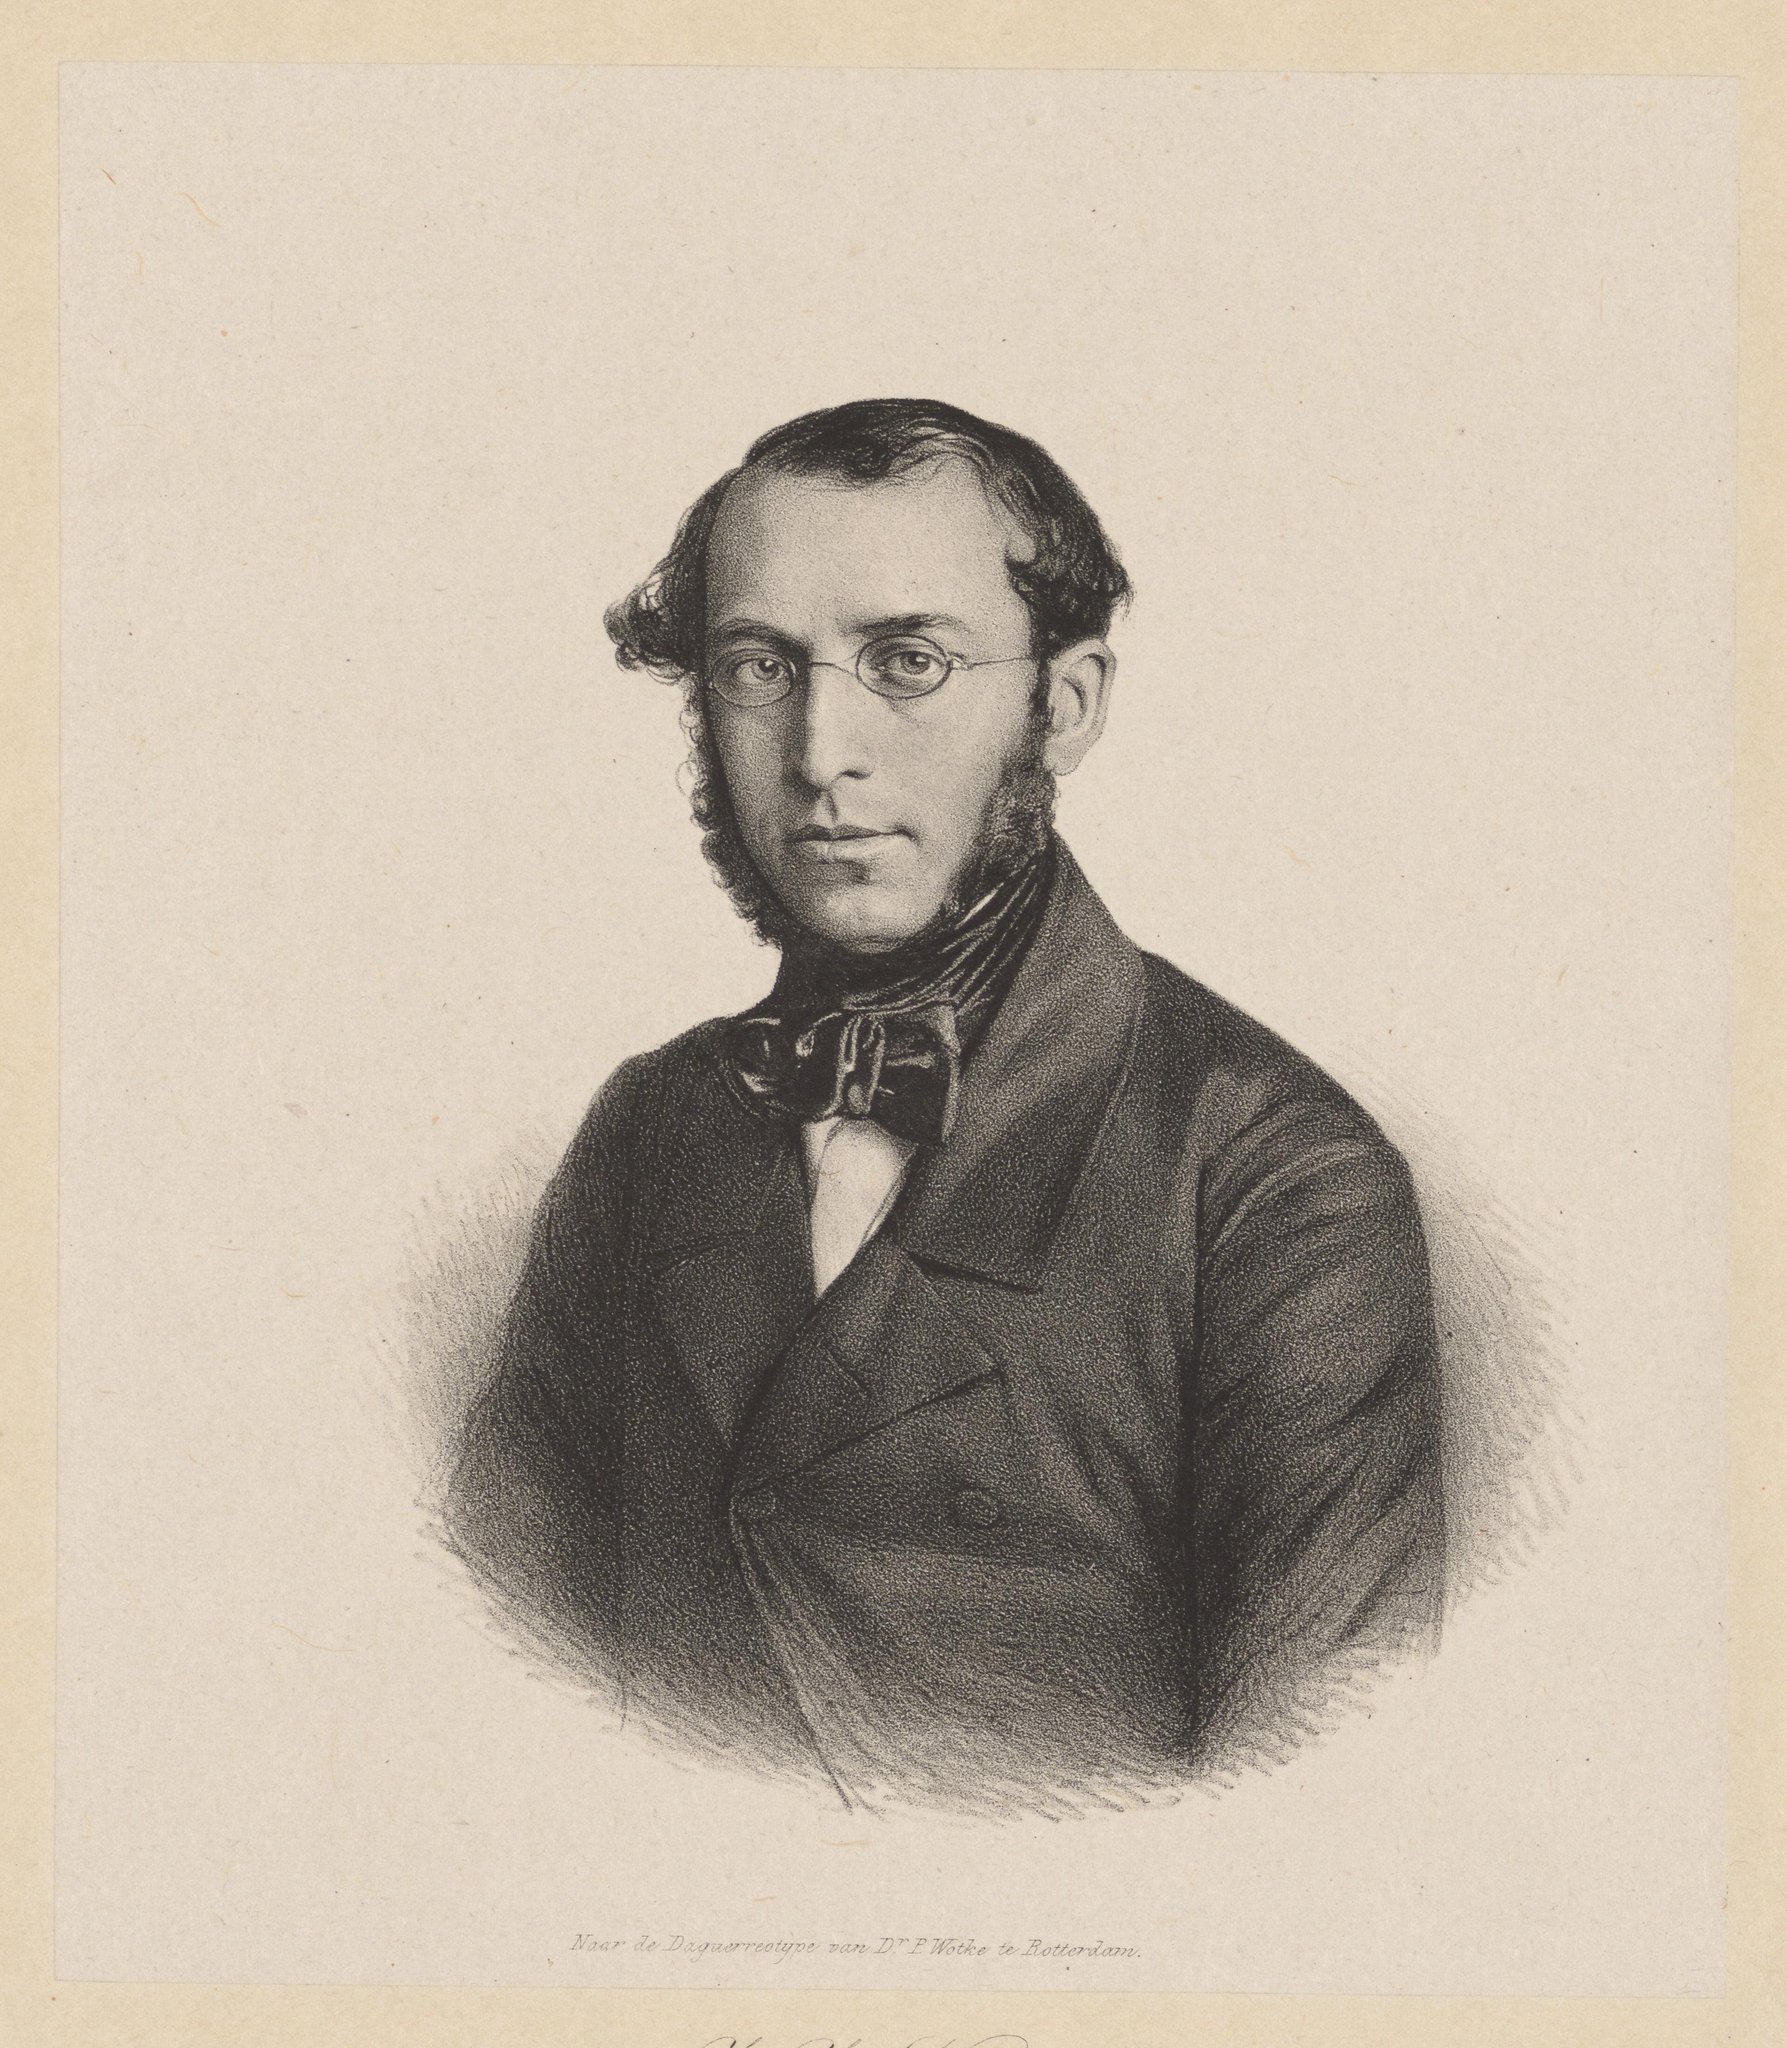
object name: print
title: Portret van Joannes Josephus Viotta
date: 1855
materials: paper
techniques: lithograph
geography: netherlands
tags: eyeglasses, spectacles, historical persons, portrait of composer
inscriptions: collector's mark: Lugt 2228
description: Prent waarschijnlijk uit: Kunstkronijk 16 (1855).